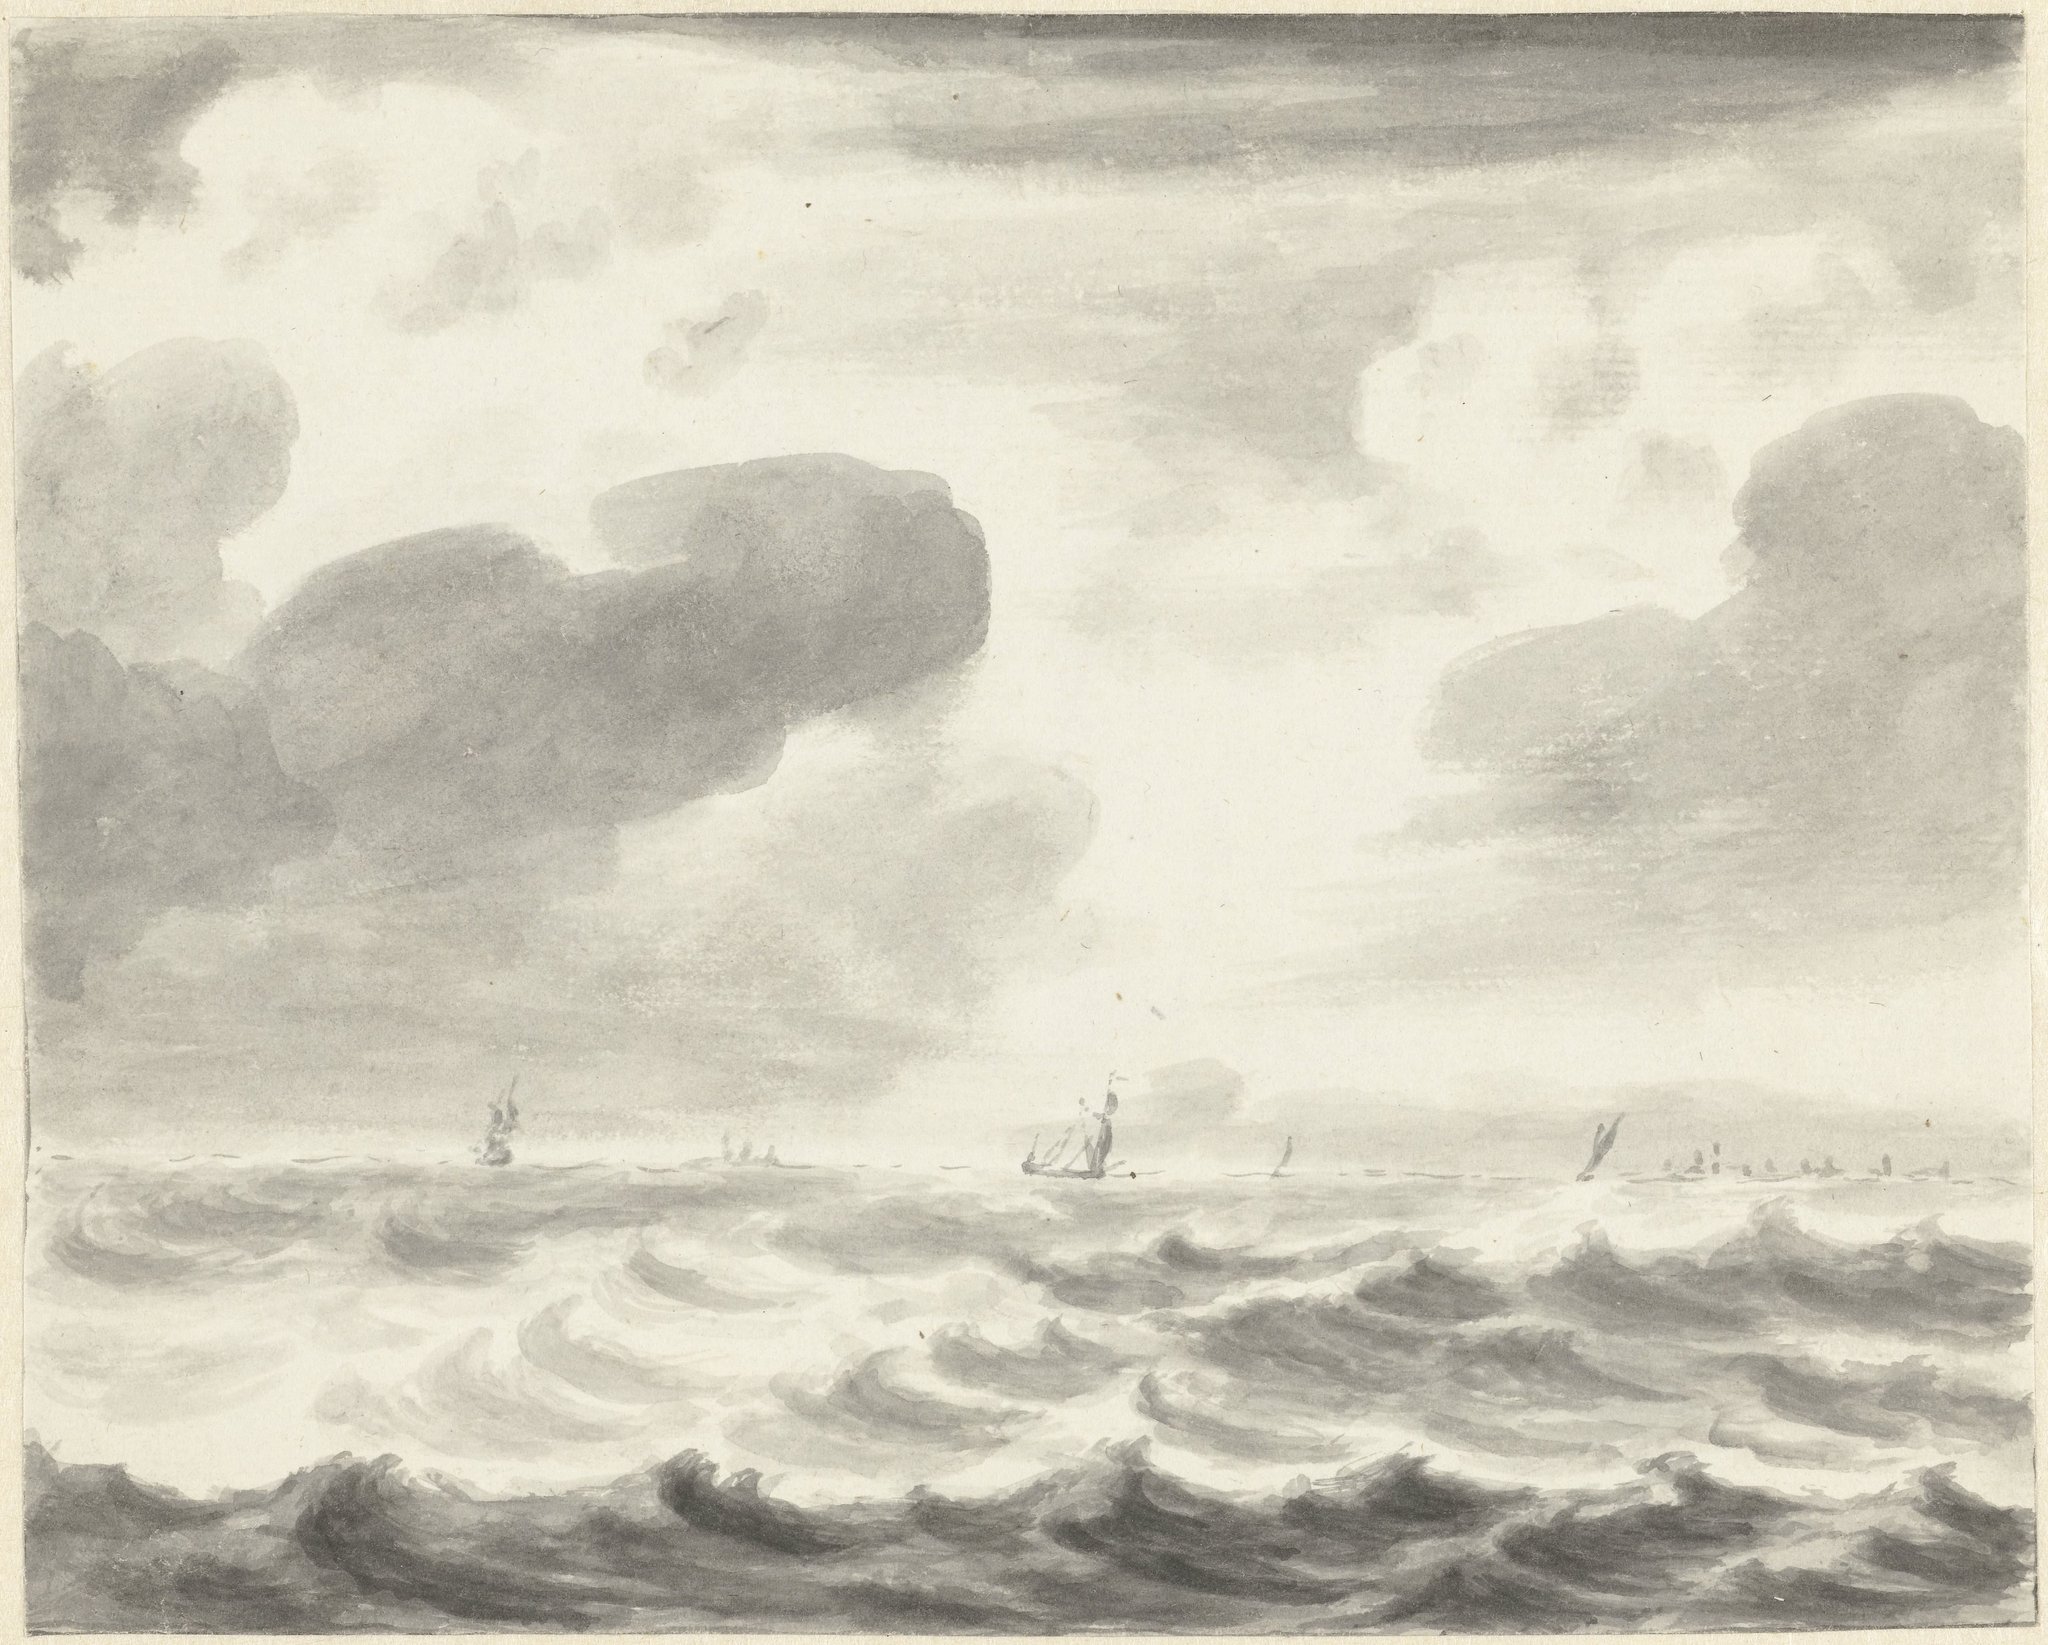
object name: drawing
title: Zeegezicht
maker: pieter idserts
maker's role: draughtsman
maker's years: 1698-1781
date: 1708-1781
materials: paper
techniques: brush